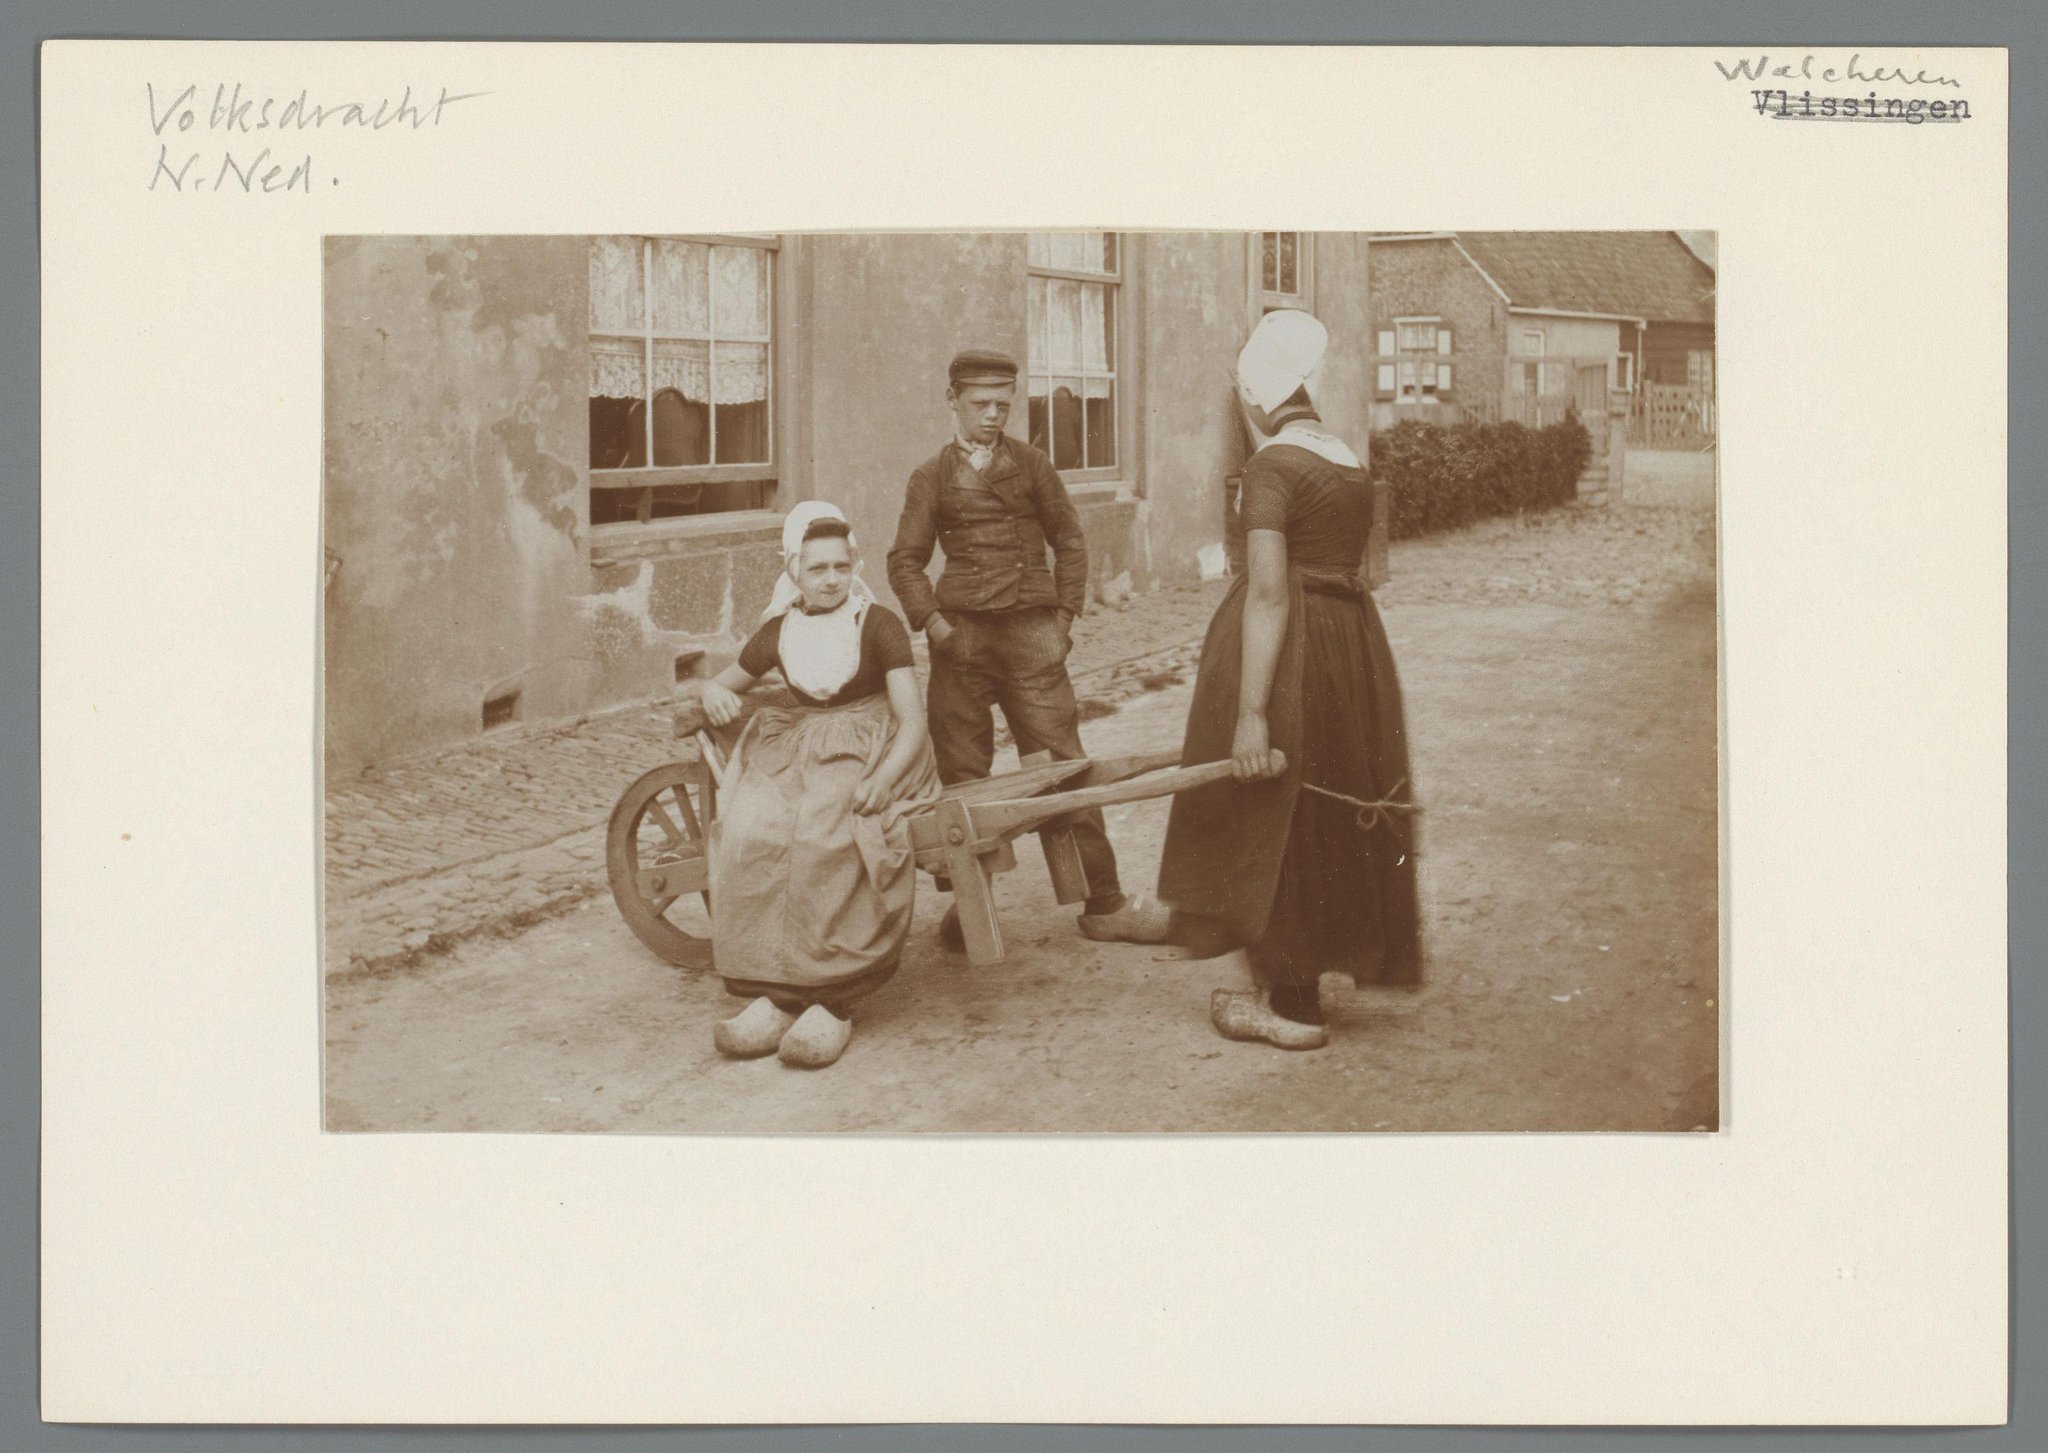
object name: photograph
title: Kinderen in Walcherse dracht op straat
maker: Anonymous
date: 1880-1920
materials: paper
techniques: collodion silver print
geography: walcheren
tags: historical persons, wheelbarrow, folk costume, regional costume, street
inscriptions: number: ‘32.838’, inscription: ‘Volksdracht/ N.Ned./ Walcheren’, number: ‘- 527078’